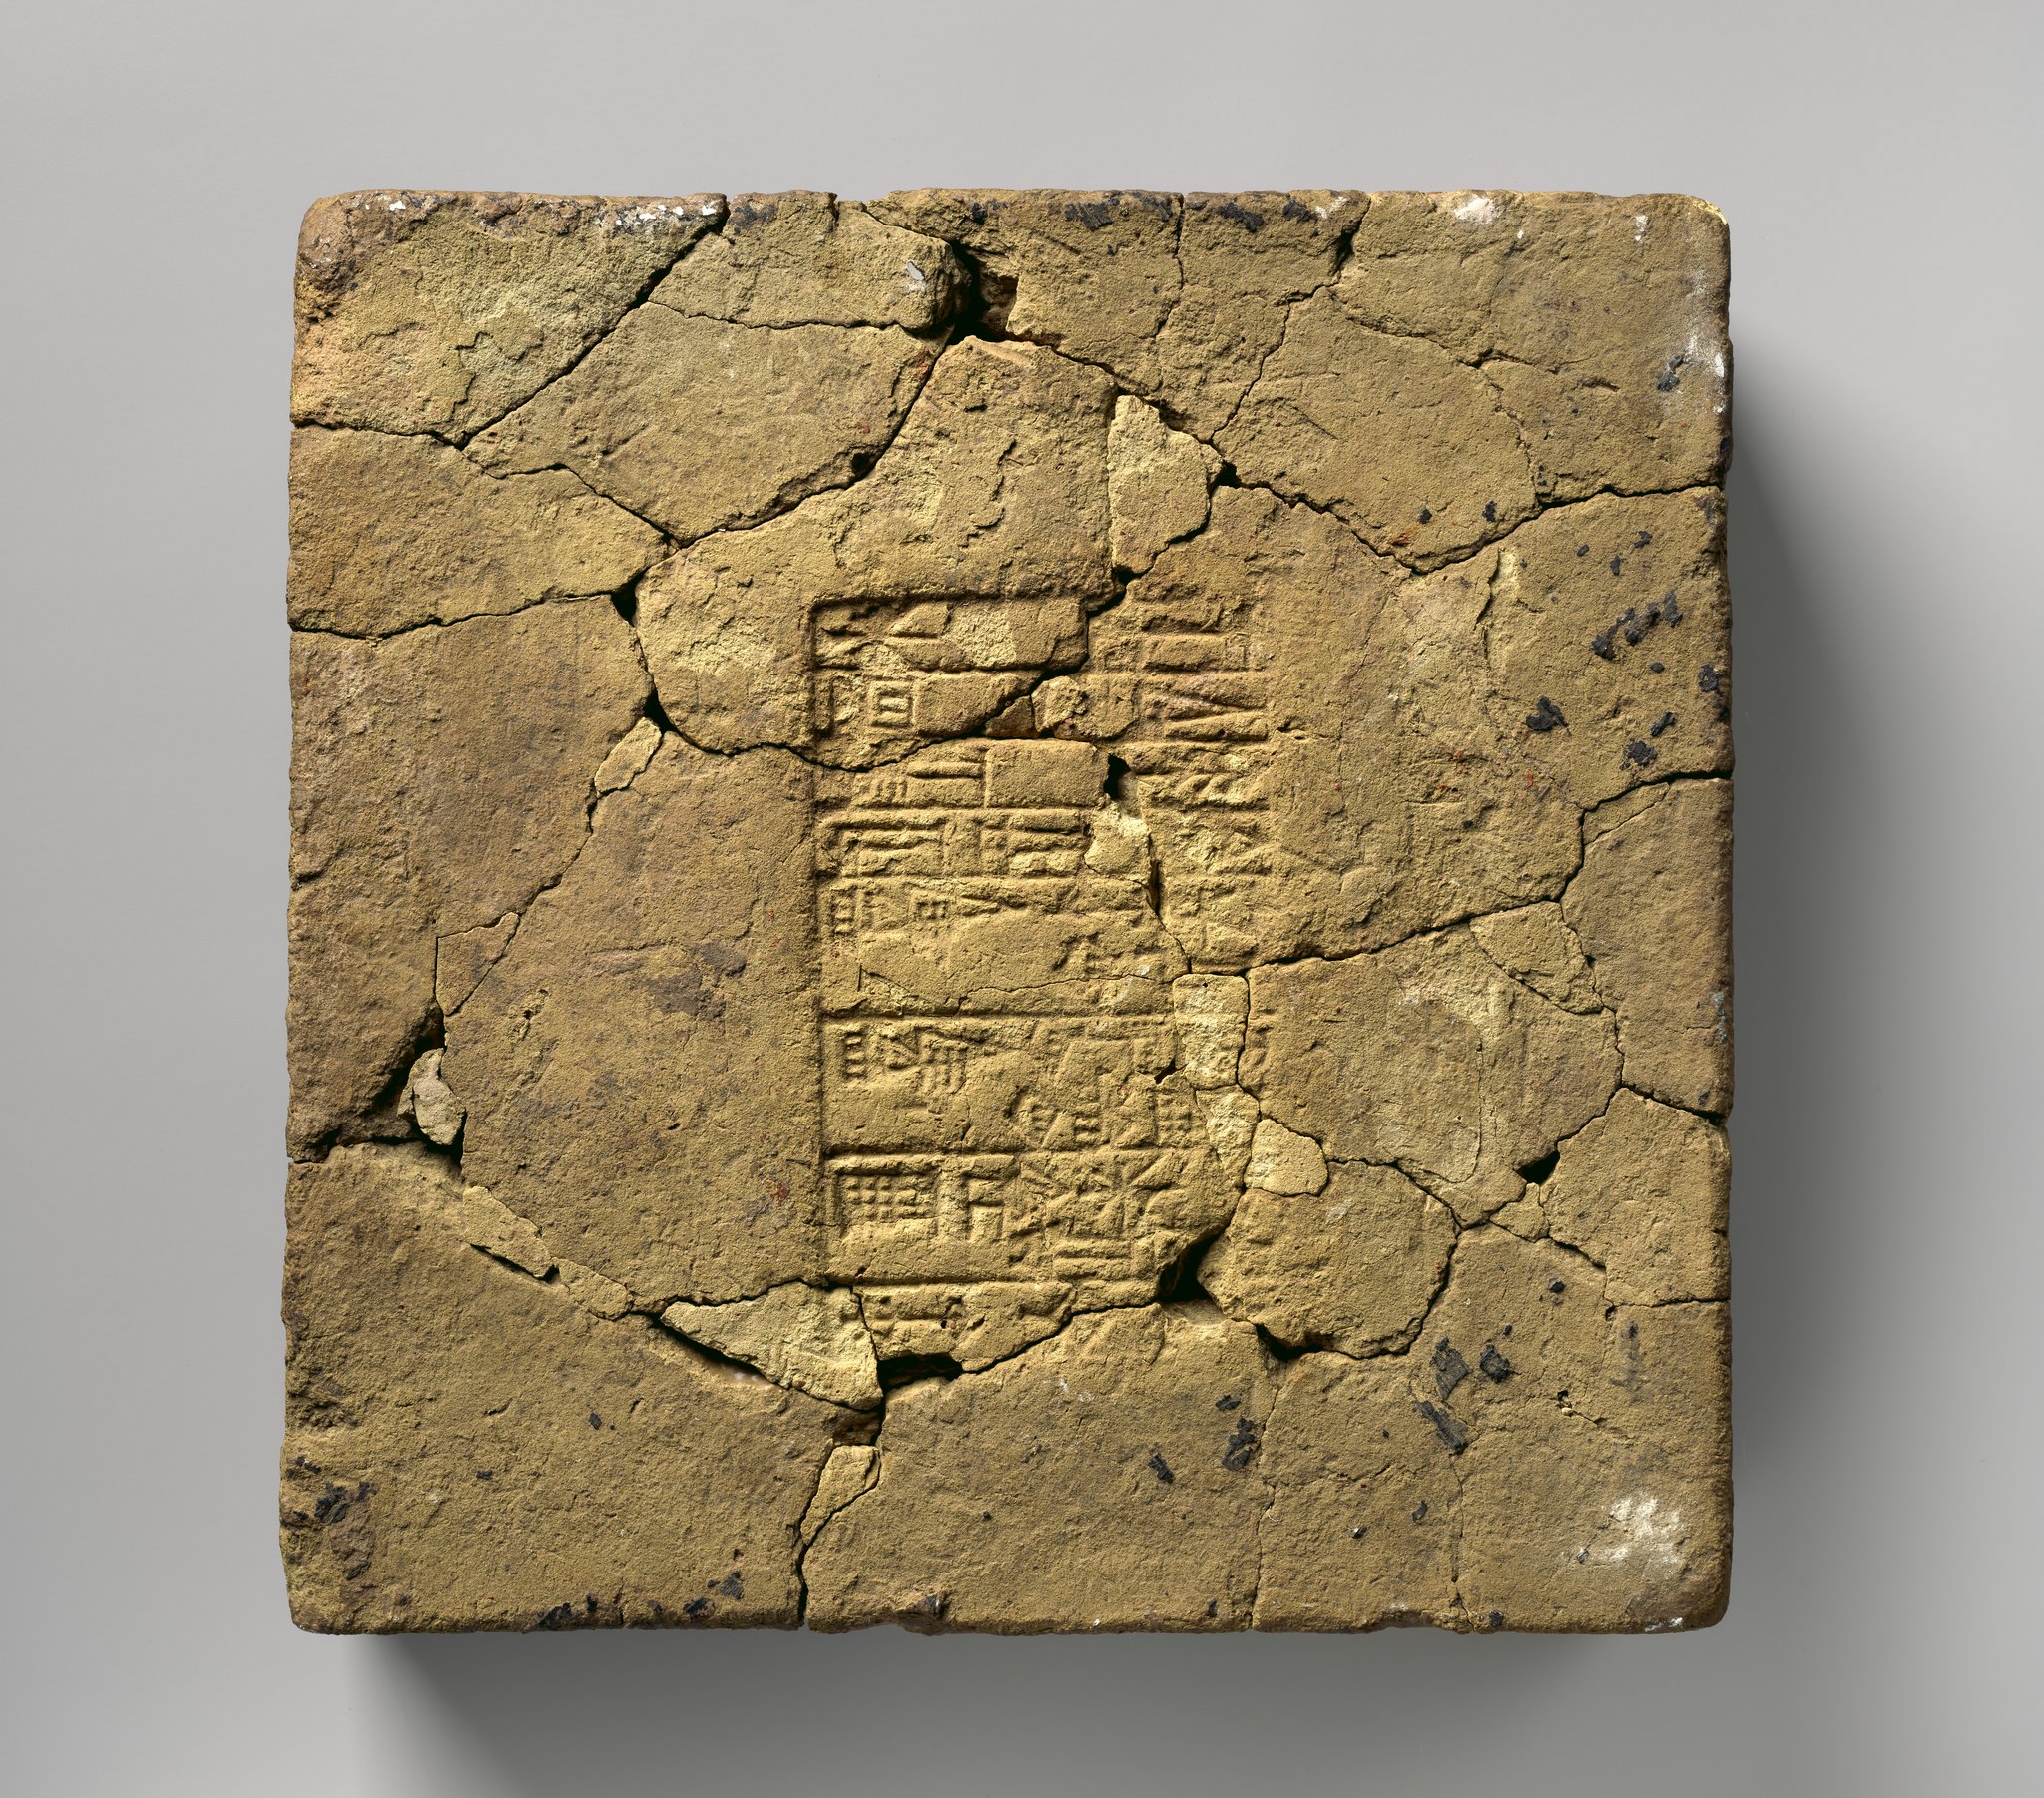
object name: brick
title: Inscribed brick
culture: neo-sumerian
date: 2094-2047 BCE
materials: ceramic, glaze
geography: mesopotamia